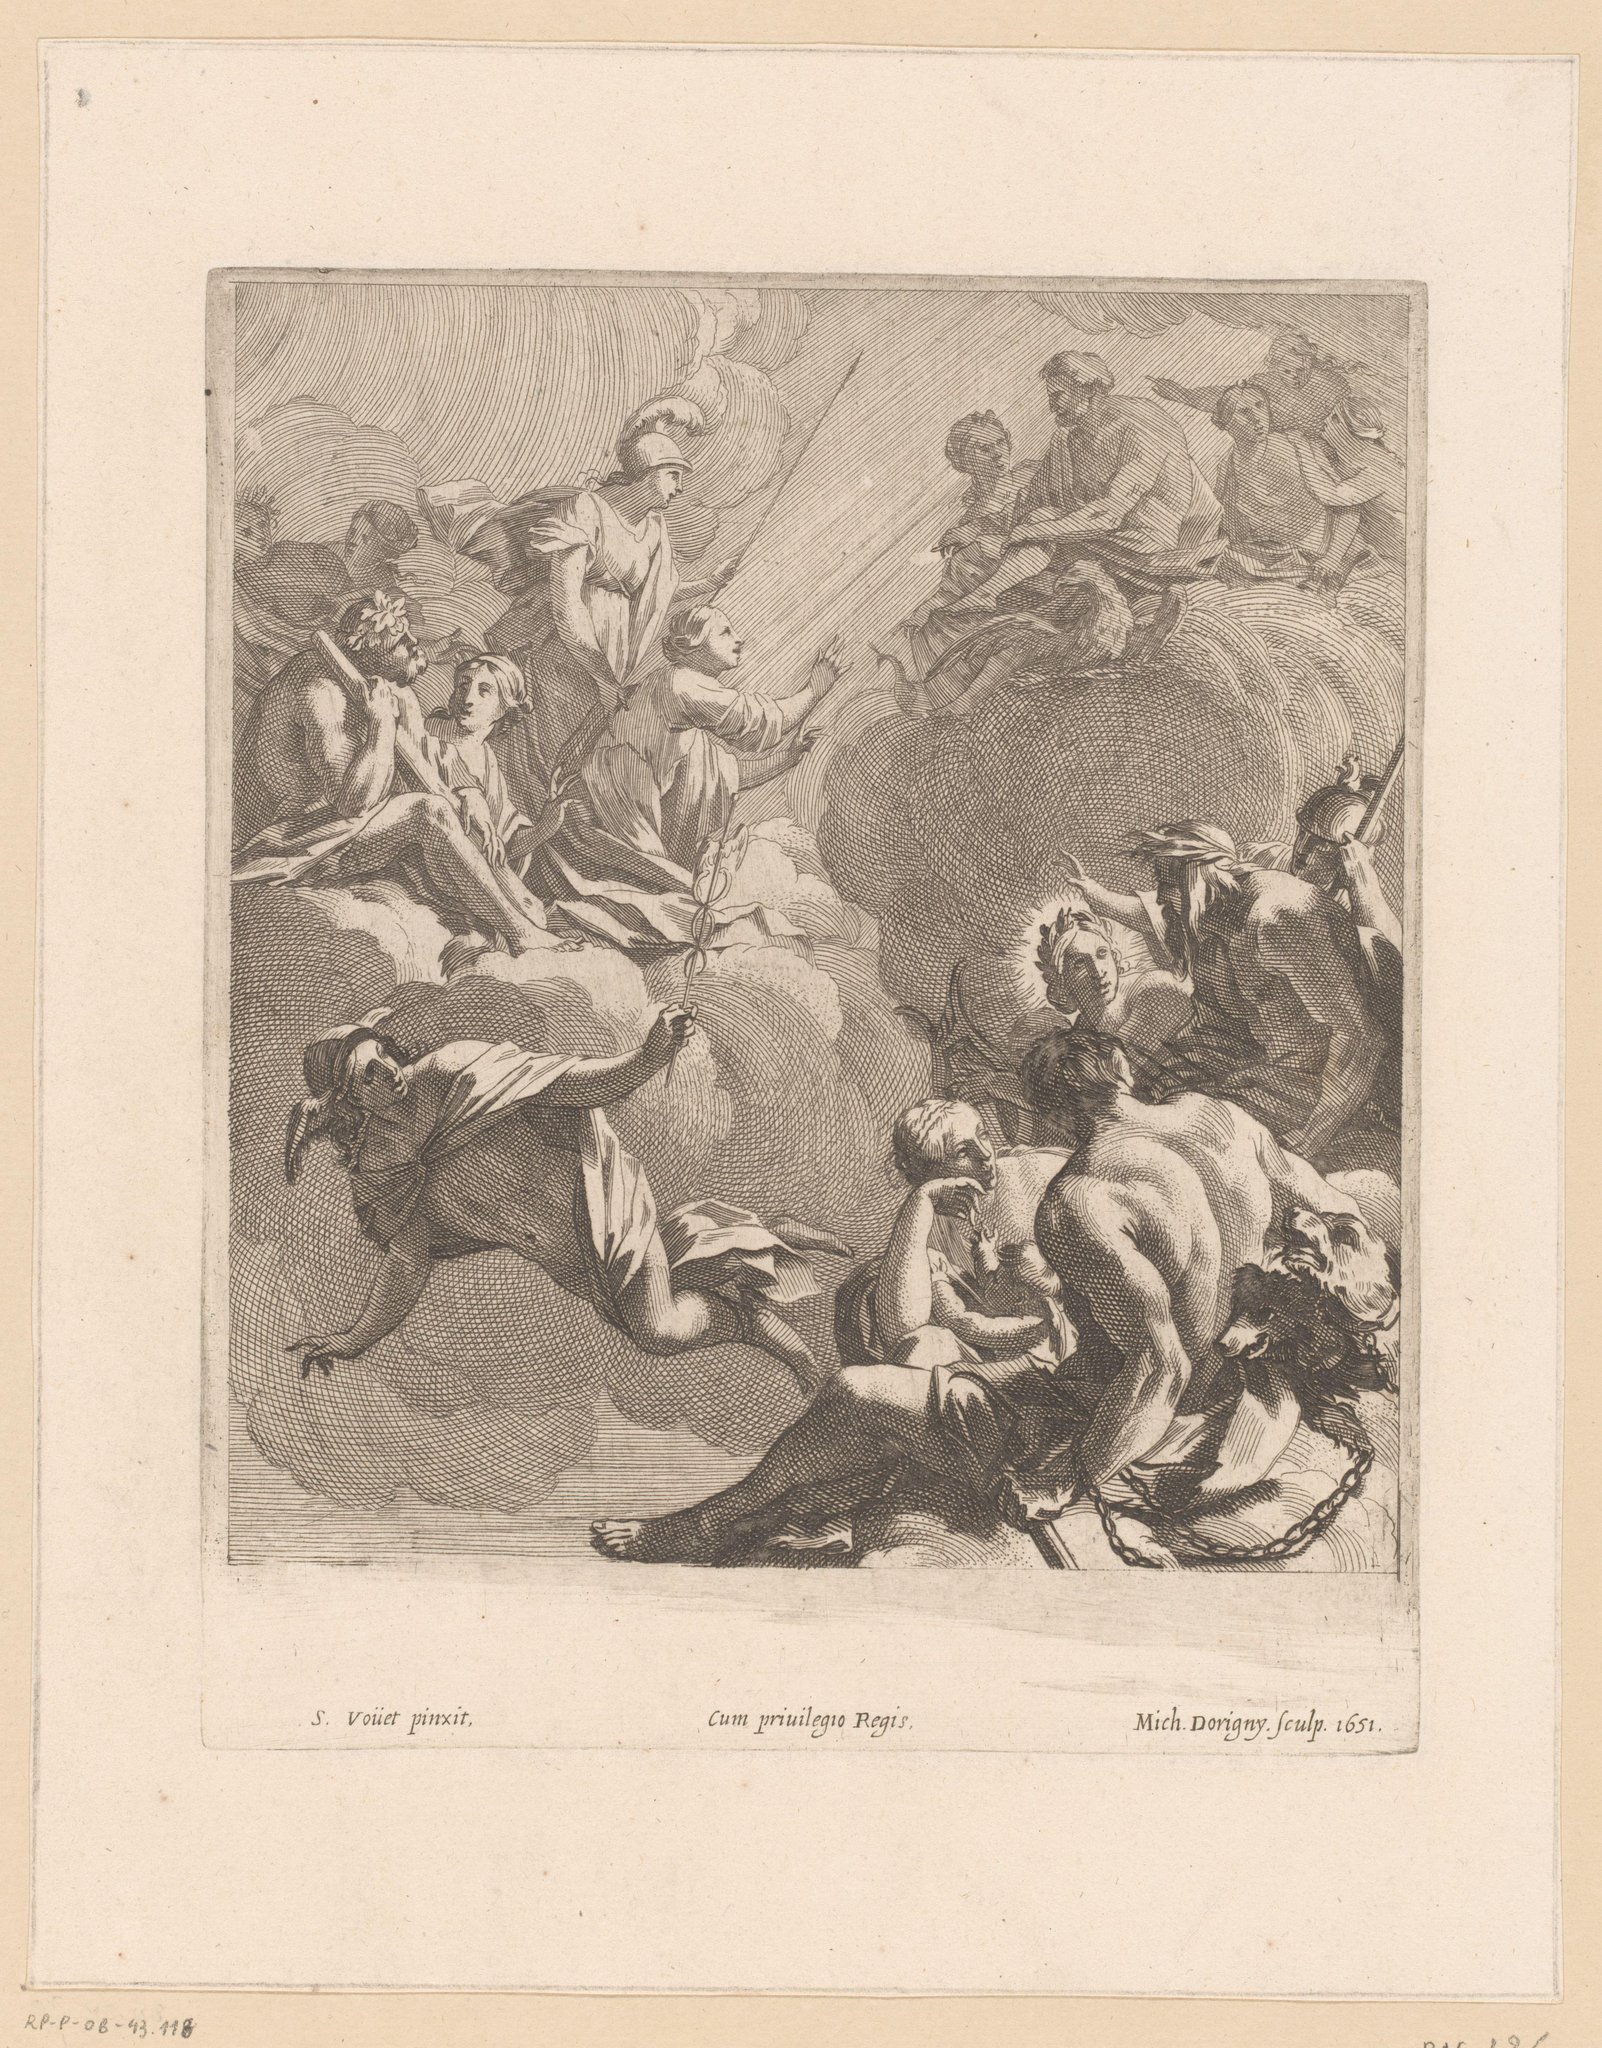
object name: print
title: Psyche op de Olympus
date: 1651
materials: paper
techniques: engraving, etching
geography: france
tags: psyche is carried up to olympus by mercury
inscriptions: collector's mark: Lugt 240